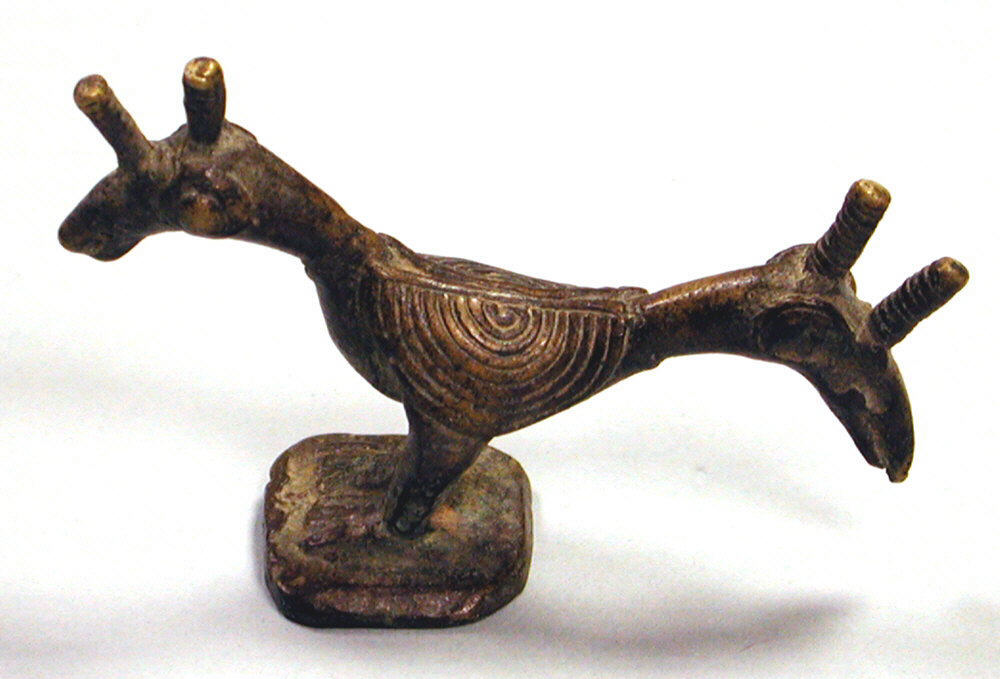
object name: weight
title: Gold Weight: Janus Bird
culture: akan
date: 1701-1900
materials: brass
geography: ghana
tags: birds